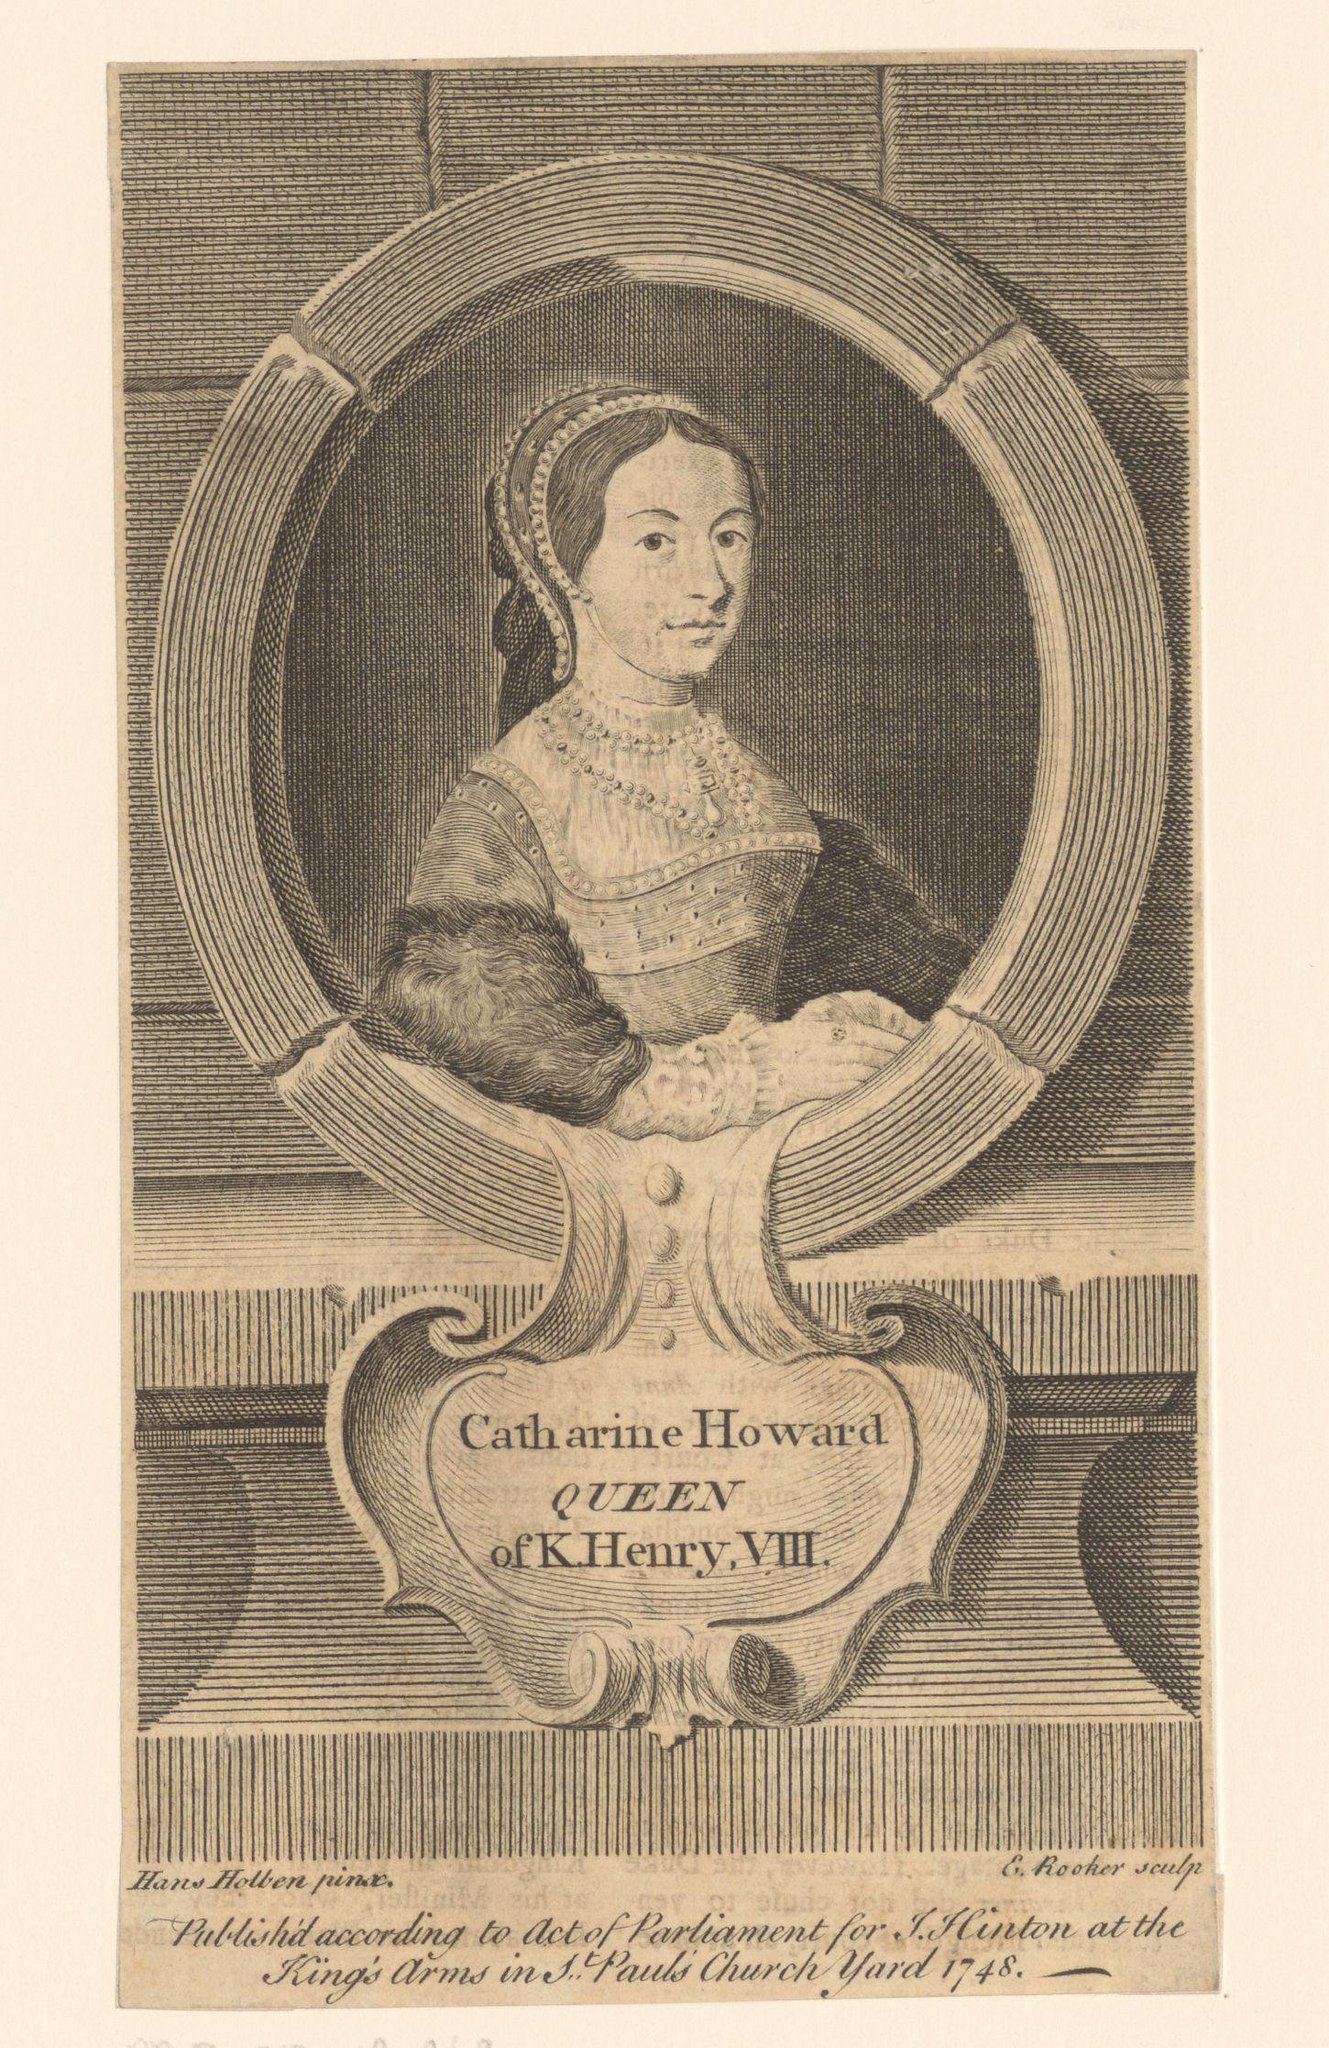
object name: print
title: Portret van Catharina Howard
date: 1748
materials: paper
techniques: engraving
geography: london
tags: london, historical persons, queen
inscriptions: collector's mark: Lugt 2228